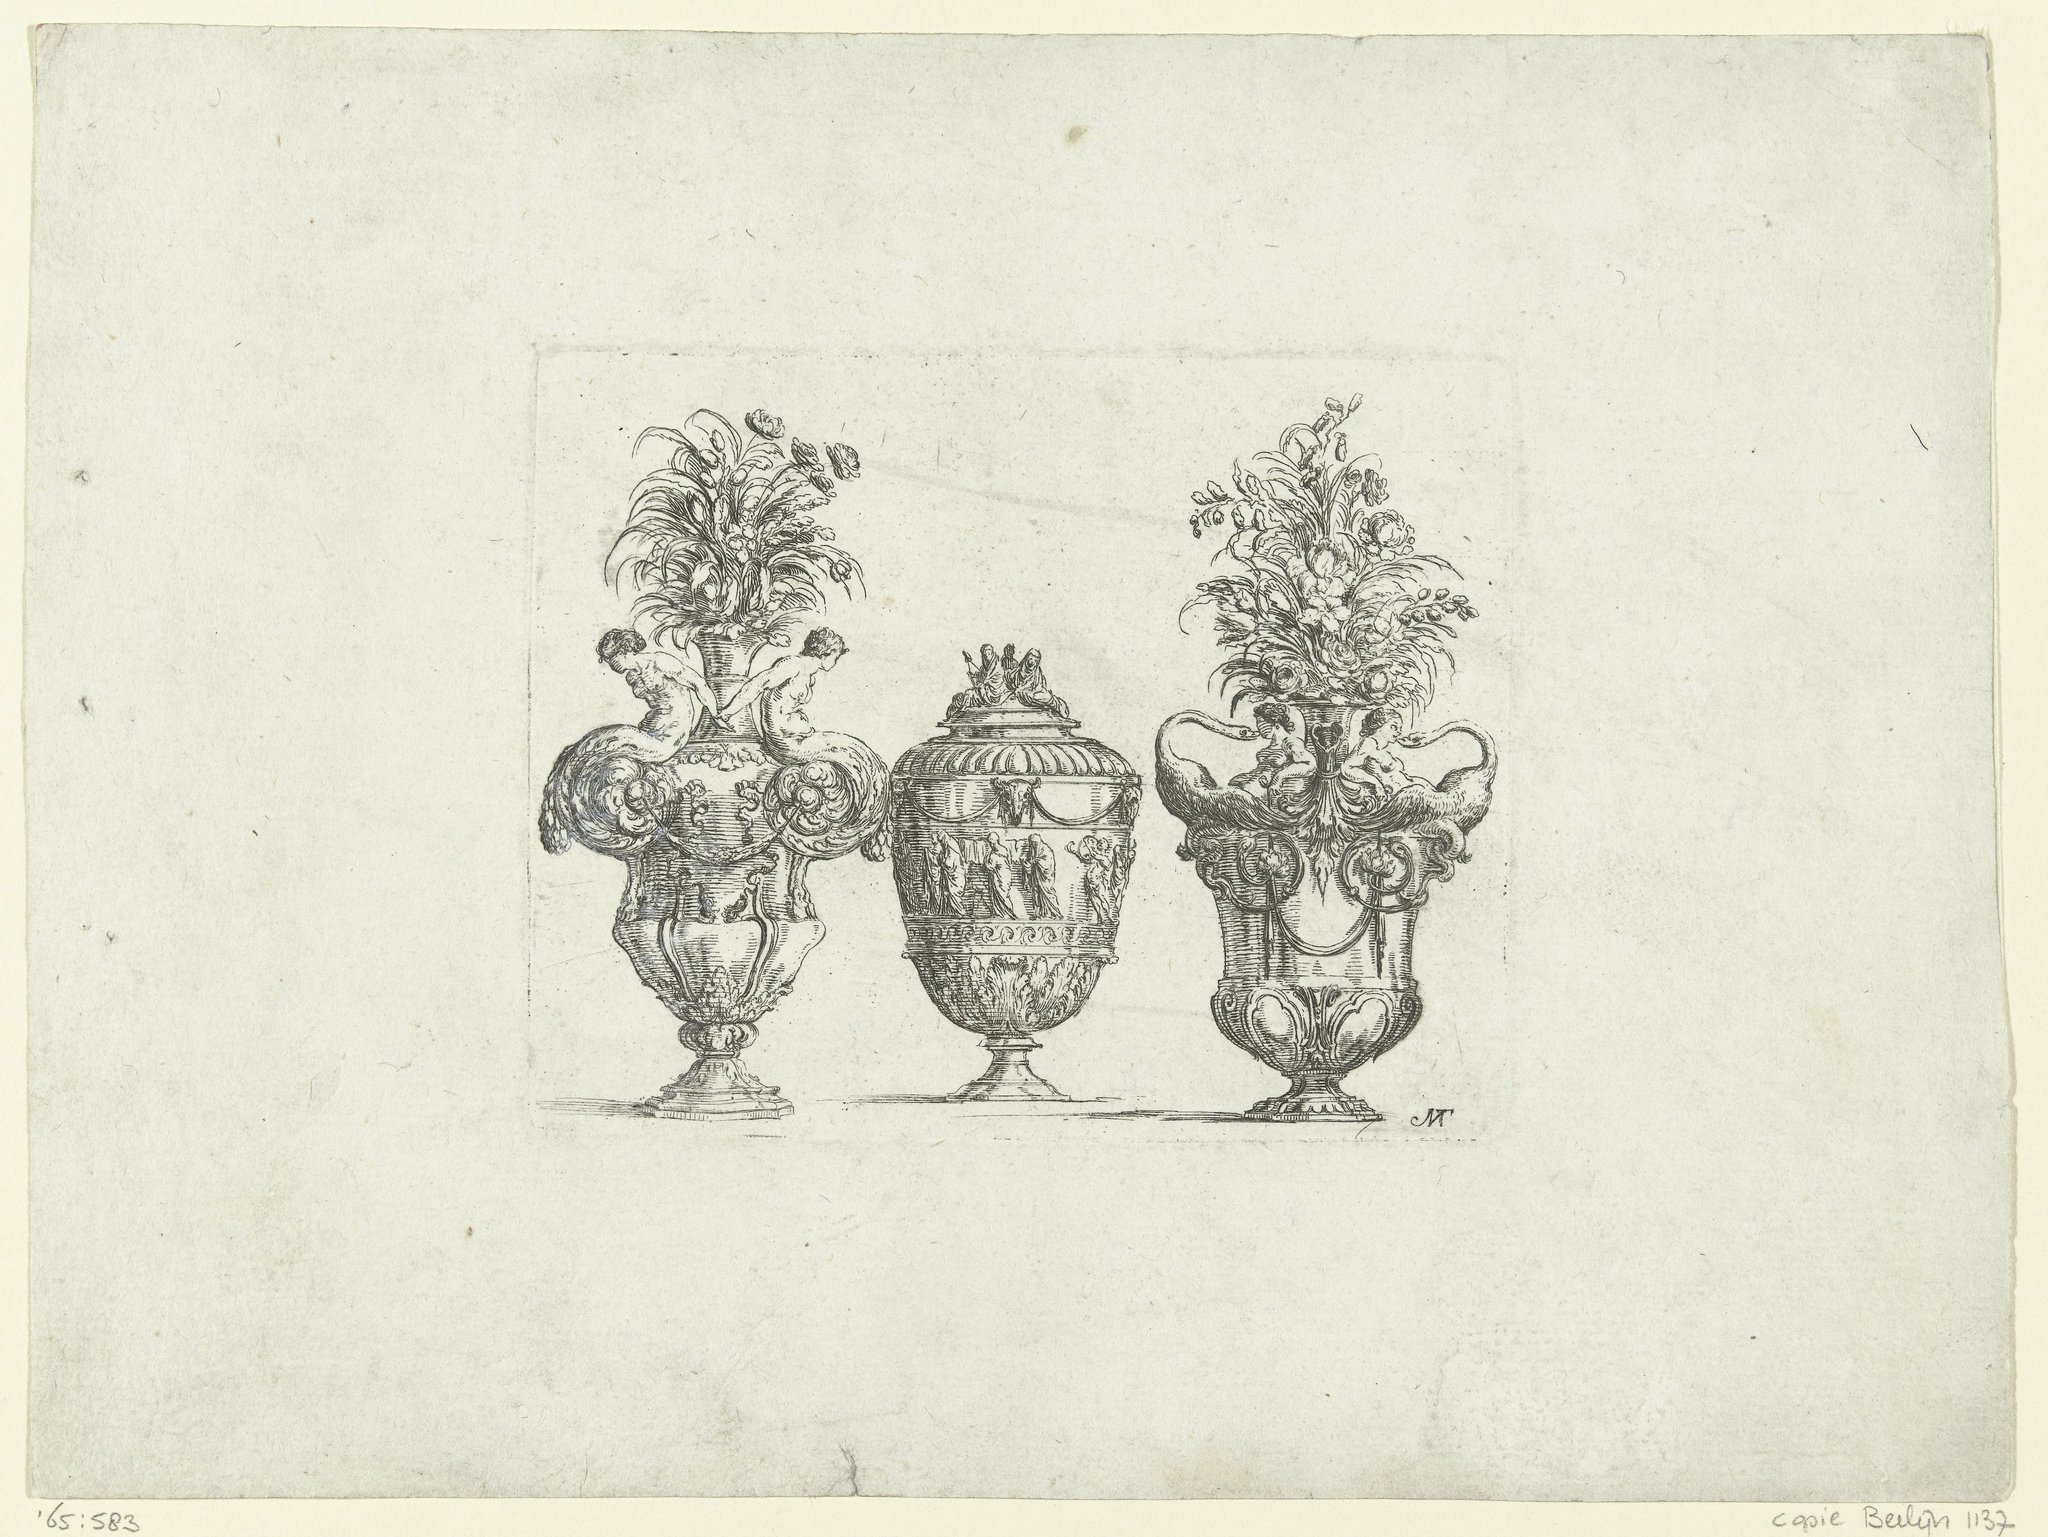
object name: print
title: Vazen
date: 1740-1766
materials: paper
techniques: etching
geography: italy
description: De vaas links is gedecoreerd met twee vrouwen wier bovenlichaam overloopt in een bladrank.